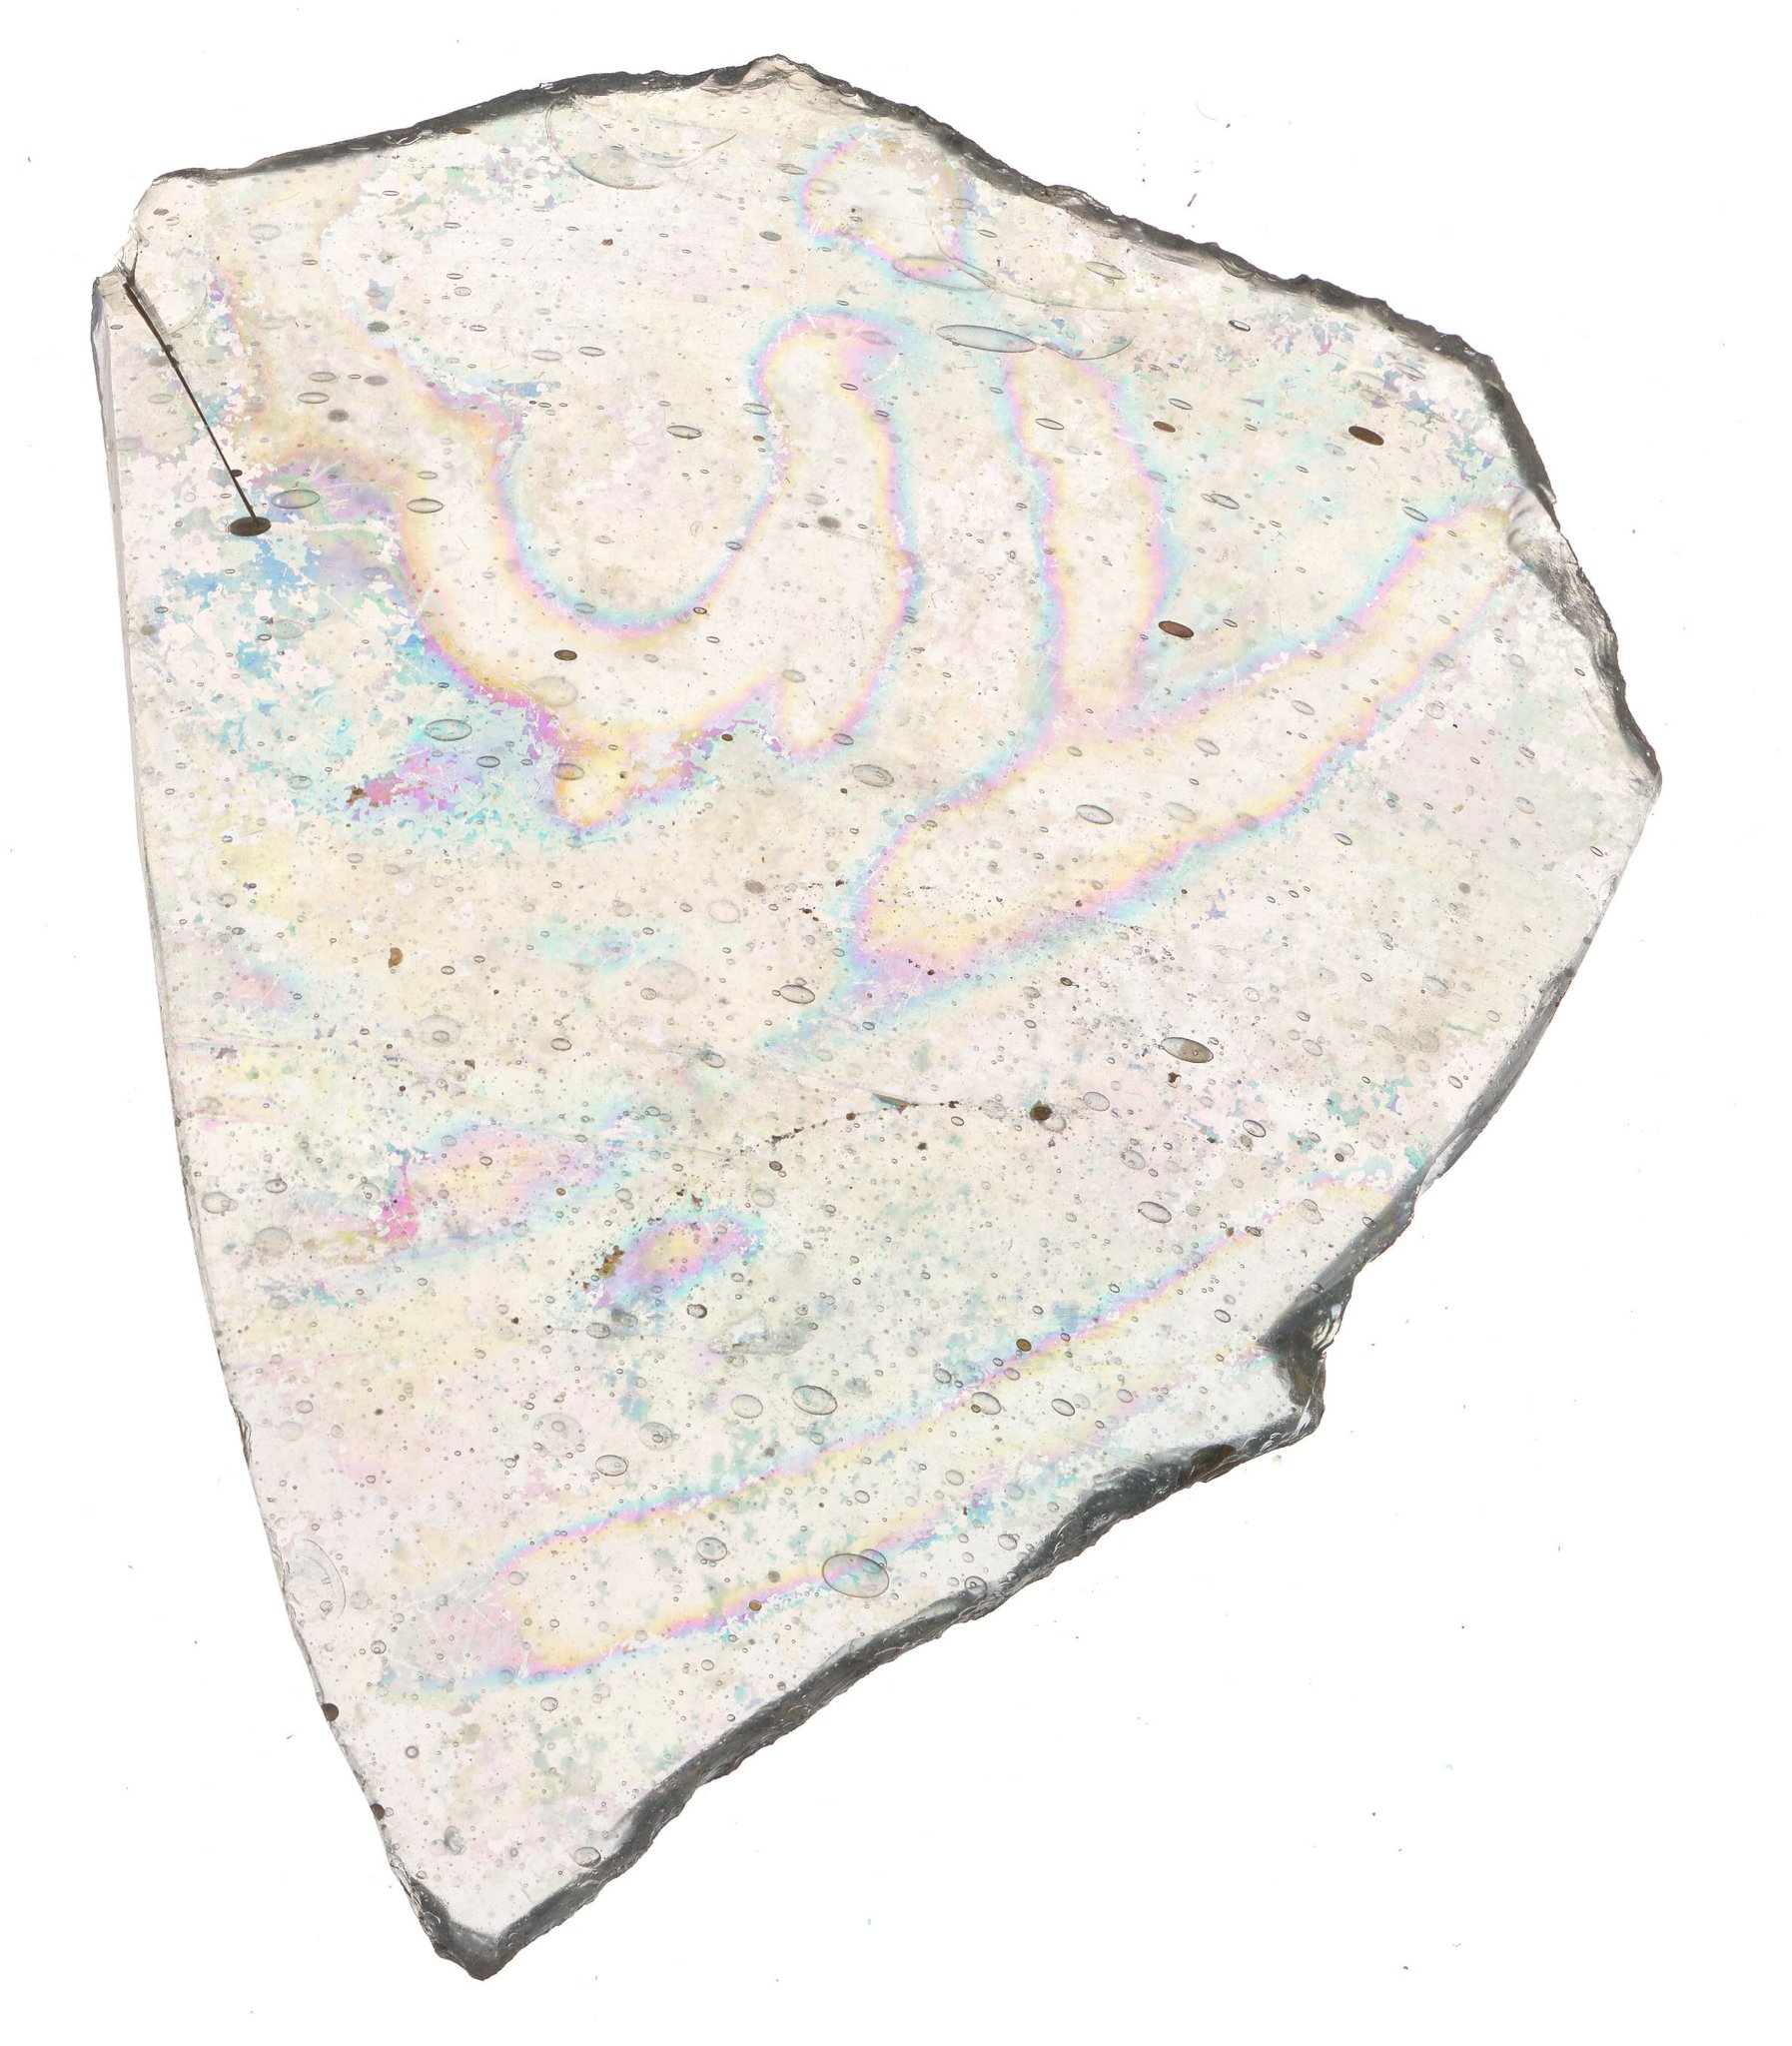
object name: fragment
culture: crusader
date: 1201-1300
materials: glass